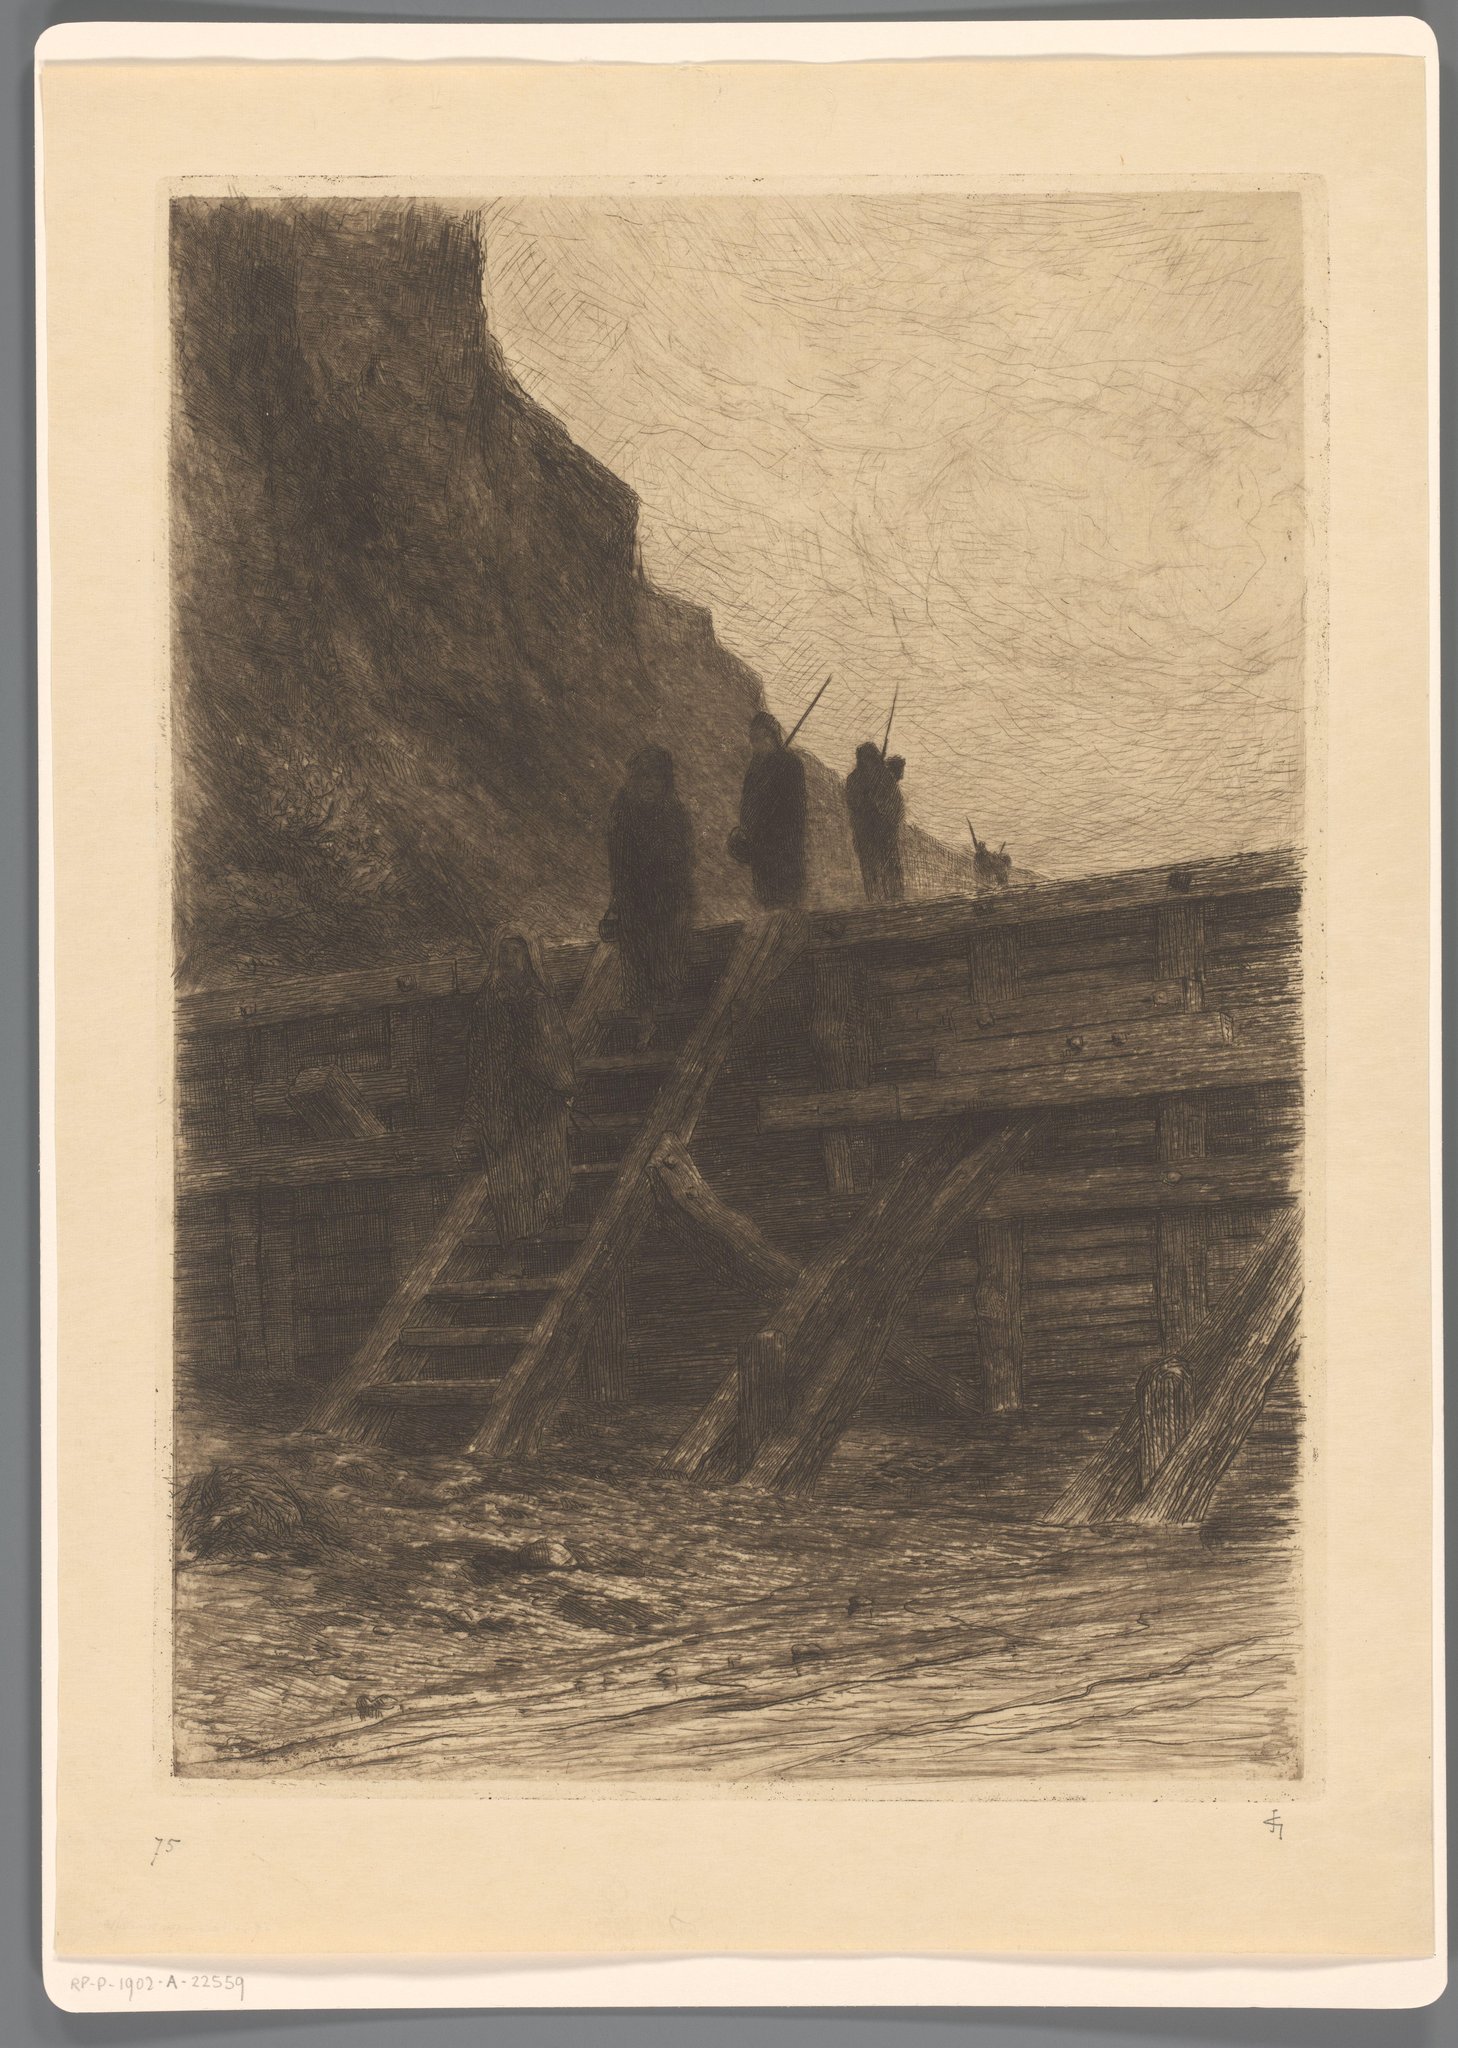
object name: print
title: Souvenir du Hâvre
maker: carel nicolaas storm van s-gravesande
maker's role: draughtsman, print maker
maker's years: 1841-1924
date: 1873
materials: paper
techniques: drypoint, etching, intaglio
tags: fisherman, sea and coastal fishery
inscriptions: collector's mark: Lugt 2228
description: Vissers lopen met emmers van een trap. Op de achtergrond rotsen.